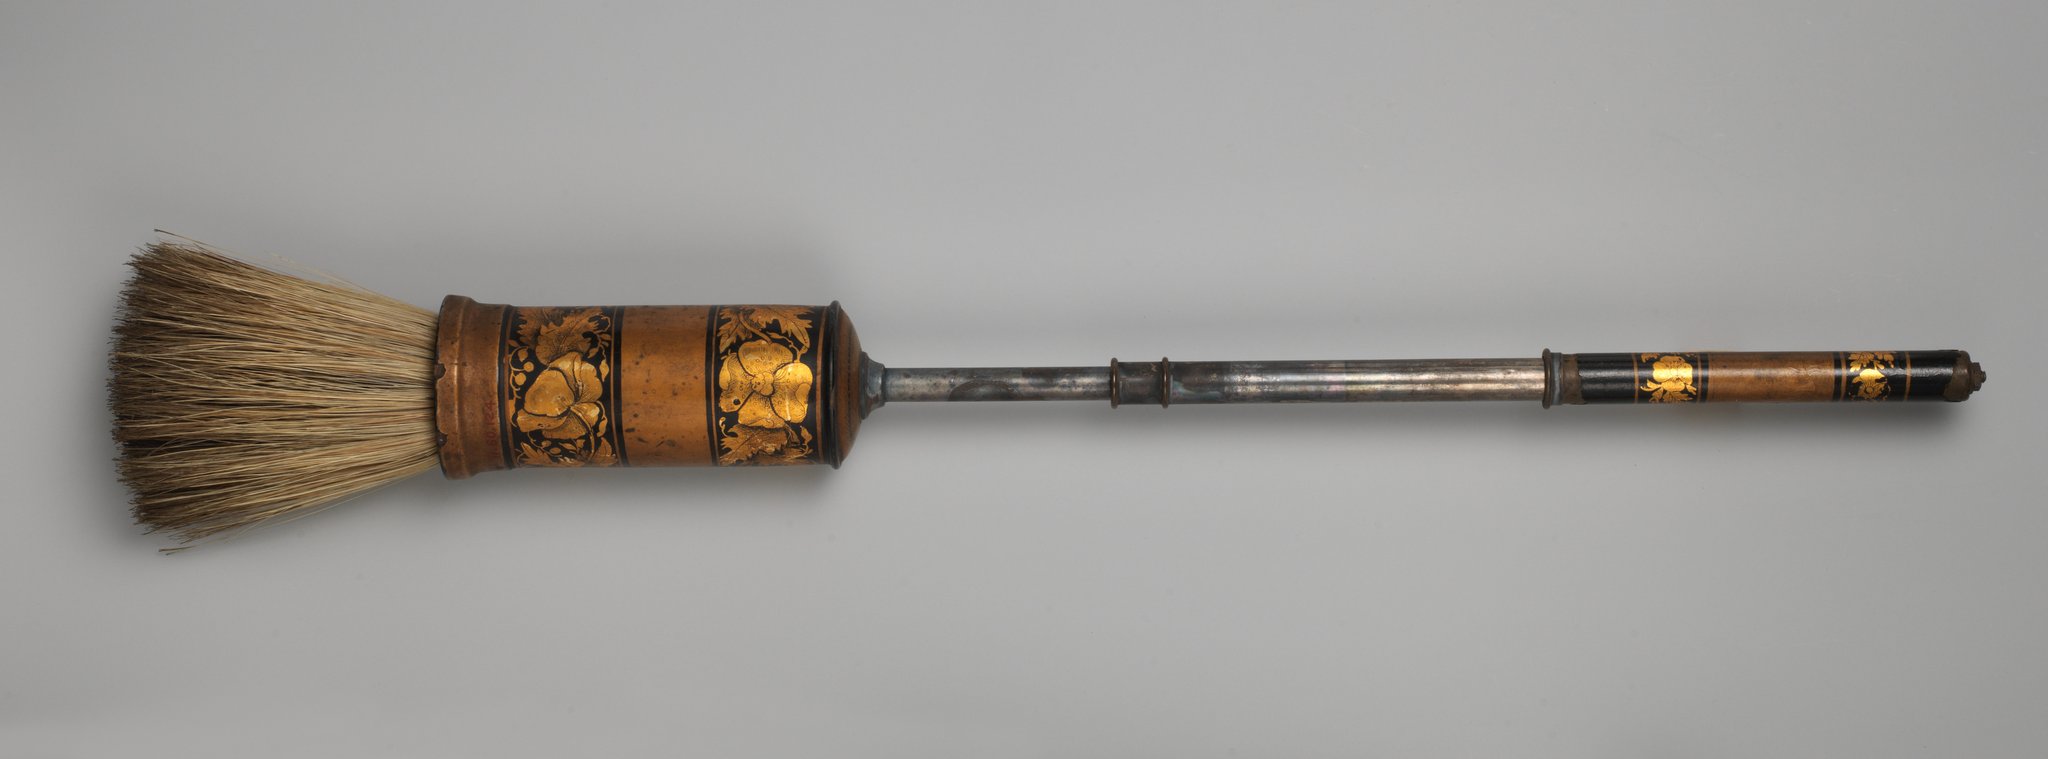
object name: brush holder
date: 1801-1833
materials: lacquer